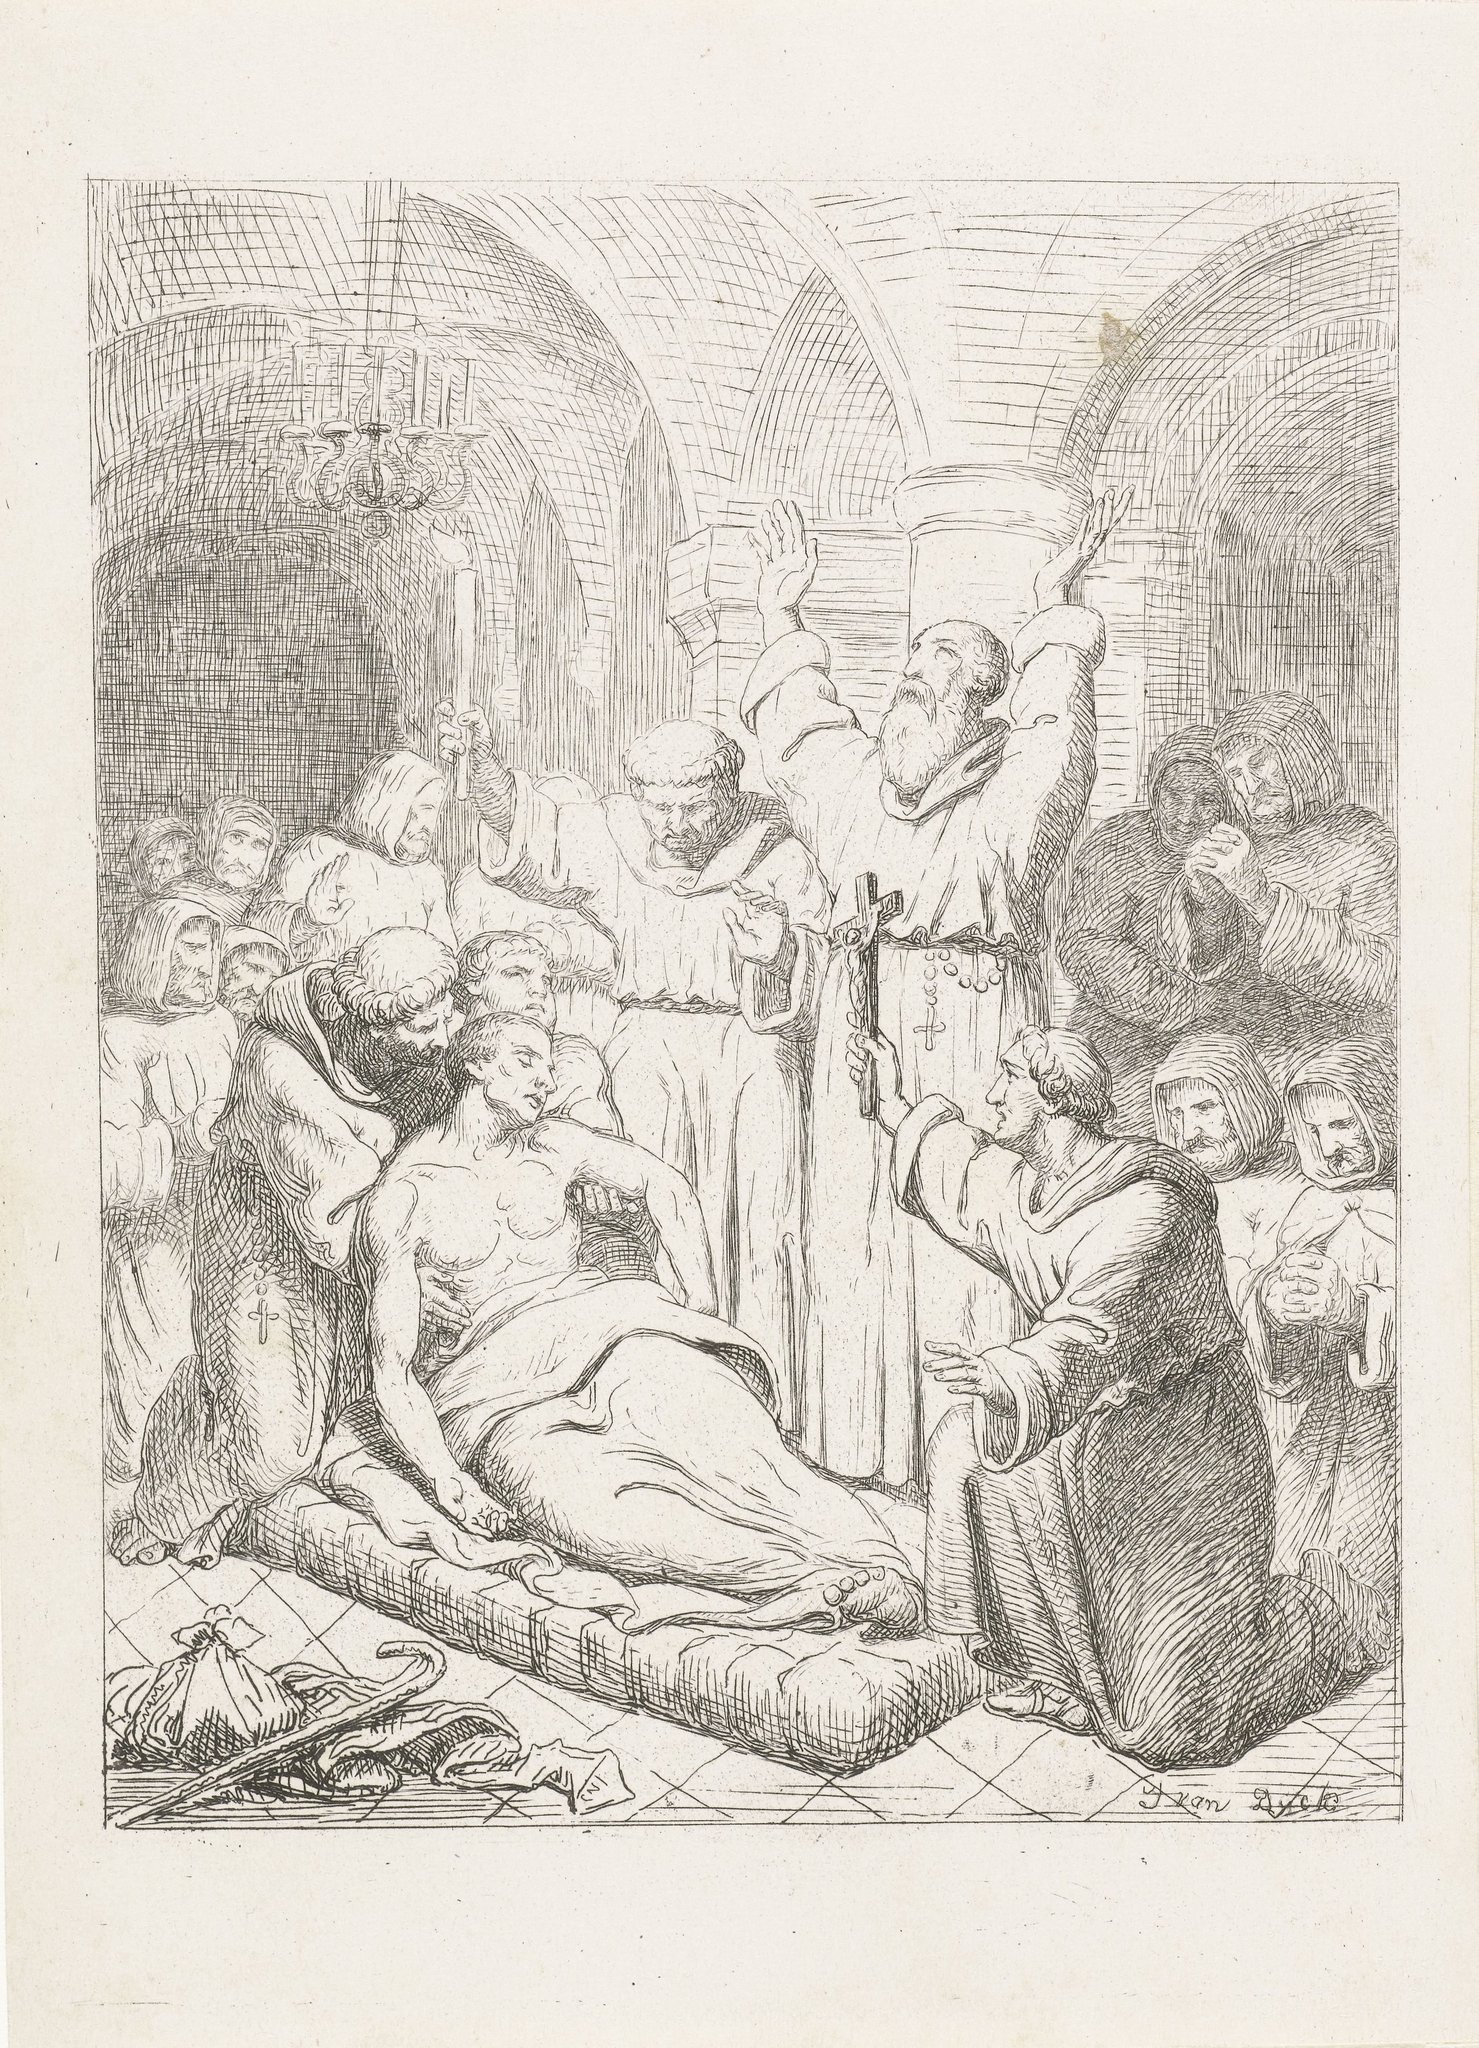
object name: book illustration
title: De dood van Tiddo Winnenga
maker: jacobus van dijck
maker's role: print maker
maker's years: 1817-1896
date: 1853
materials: paper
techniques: etching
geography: netherlands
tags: deathbed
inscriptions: collector's mark: Lugt 2228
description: Tiddo Winnenga sterft in het klooster Palmaar in begeleiding van de kloosterlingen en de abt. Illustratie voor het verhaal Tiddo Winnengha van J.J. van der Horst.